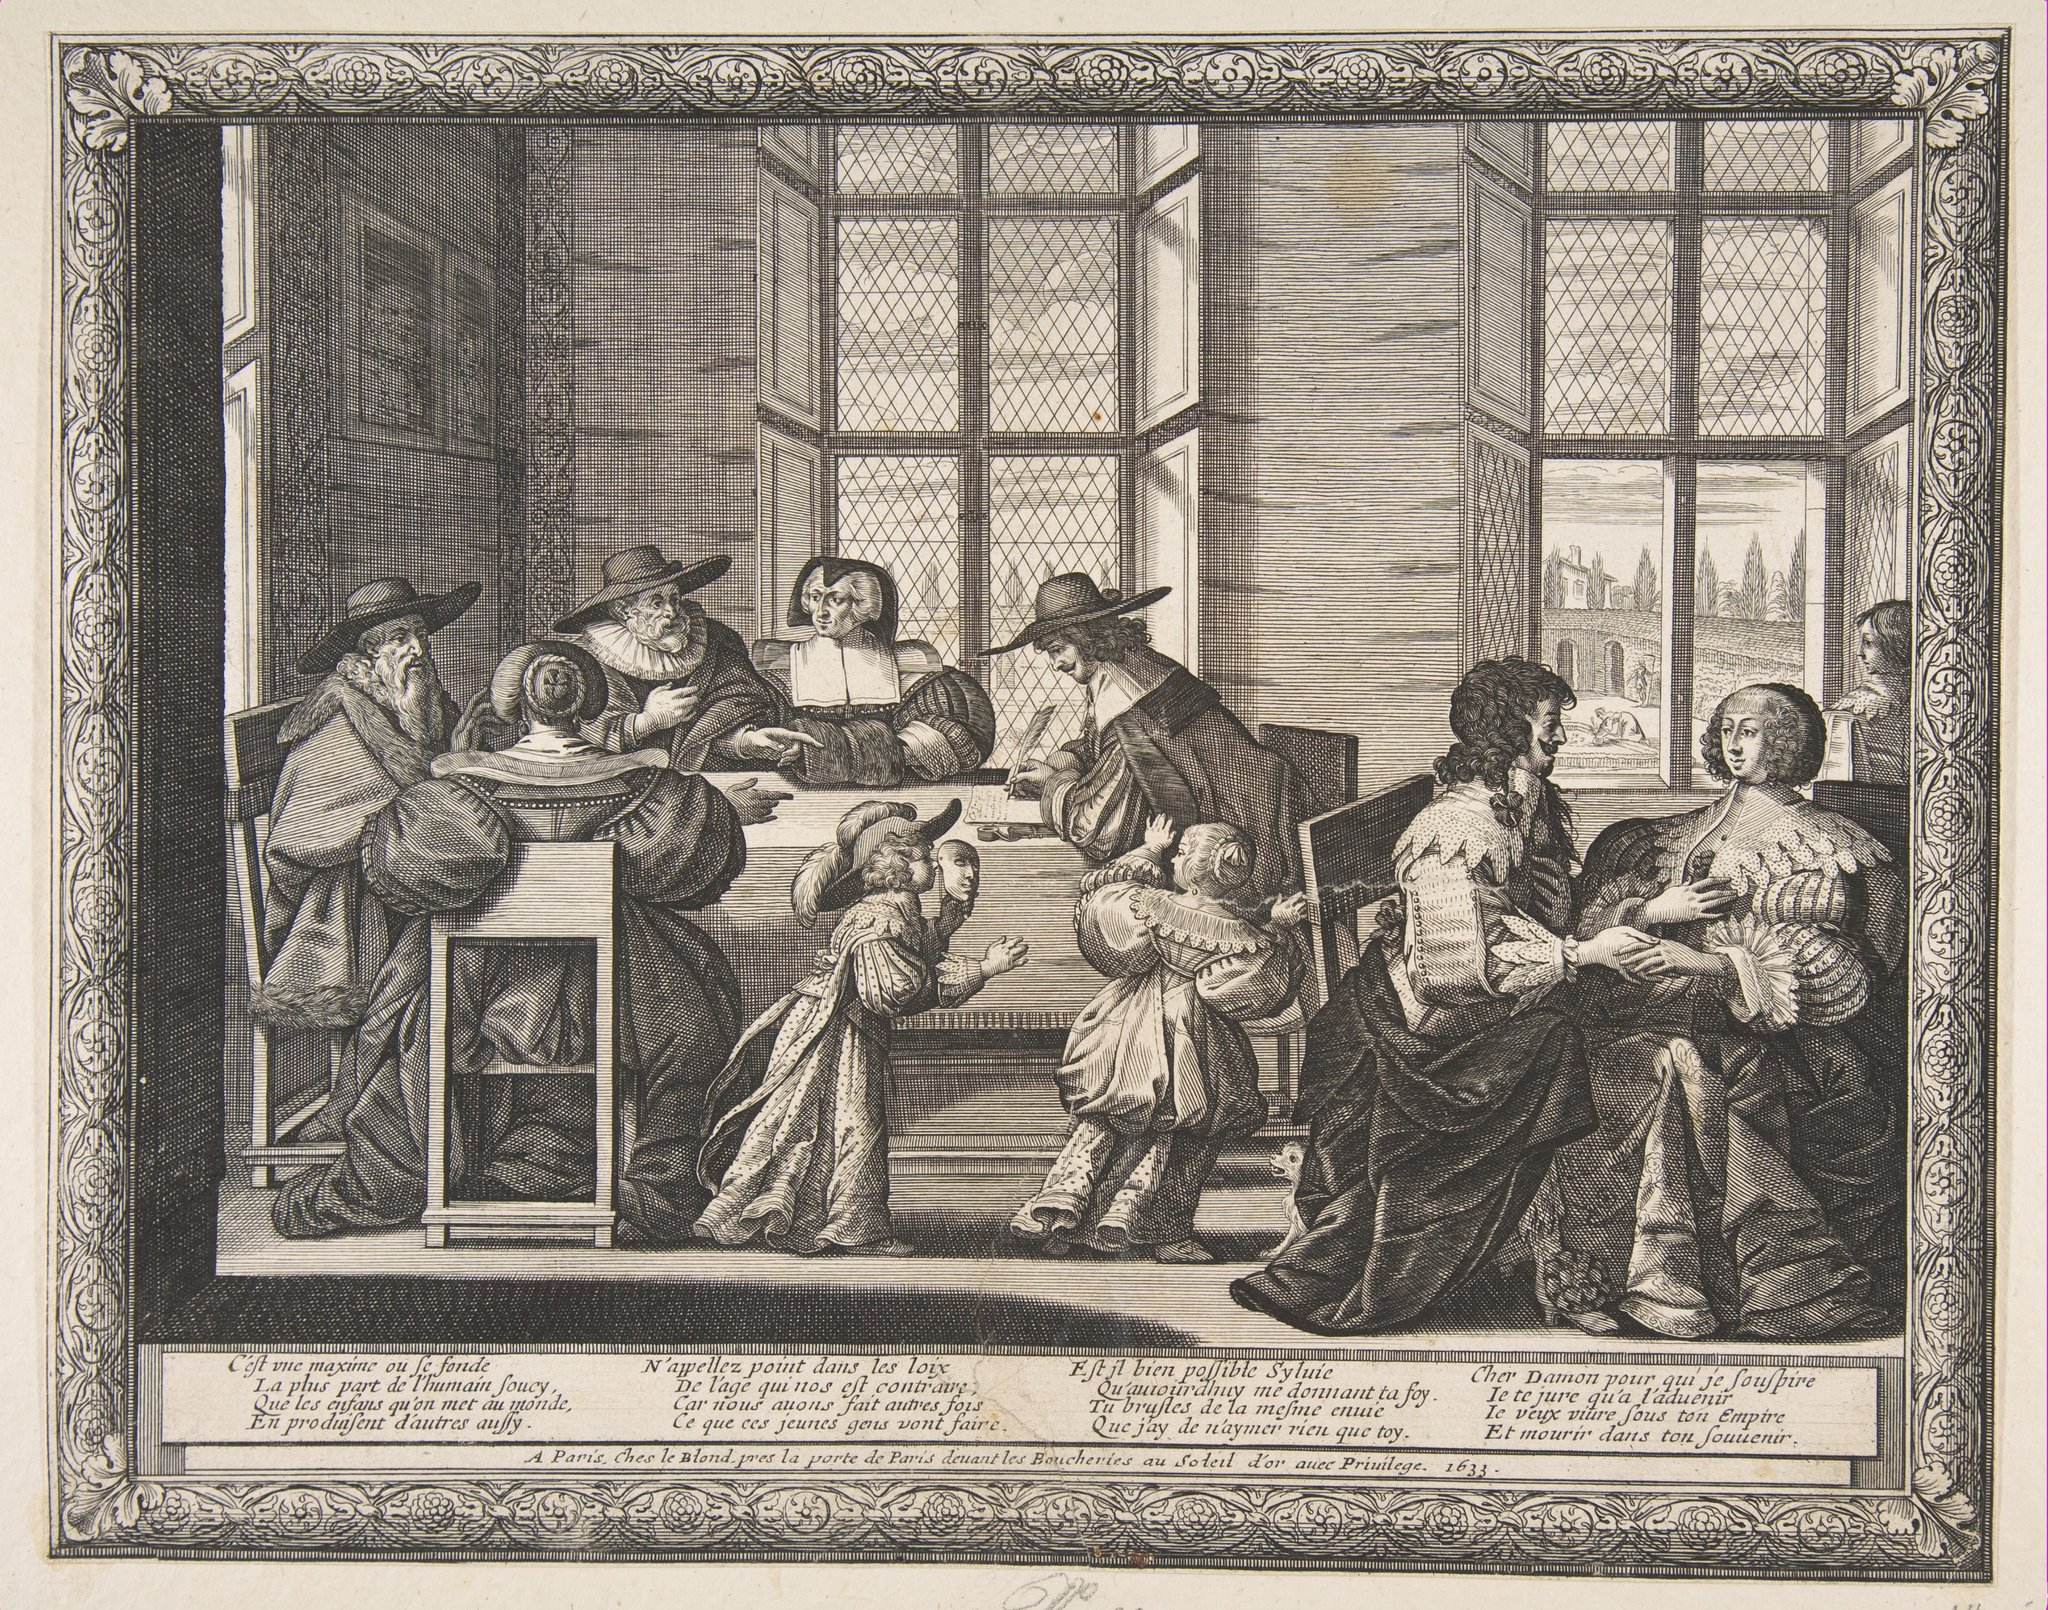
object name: print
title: The Marriage Contract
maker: abraham bosse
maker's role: artist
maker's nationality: french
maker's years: 1602-1676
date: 1633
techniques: etching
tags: children,men,women,writing